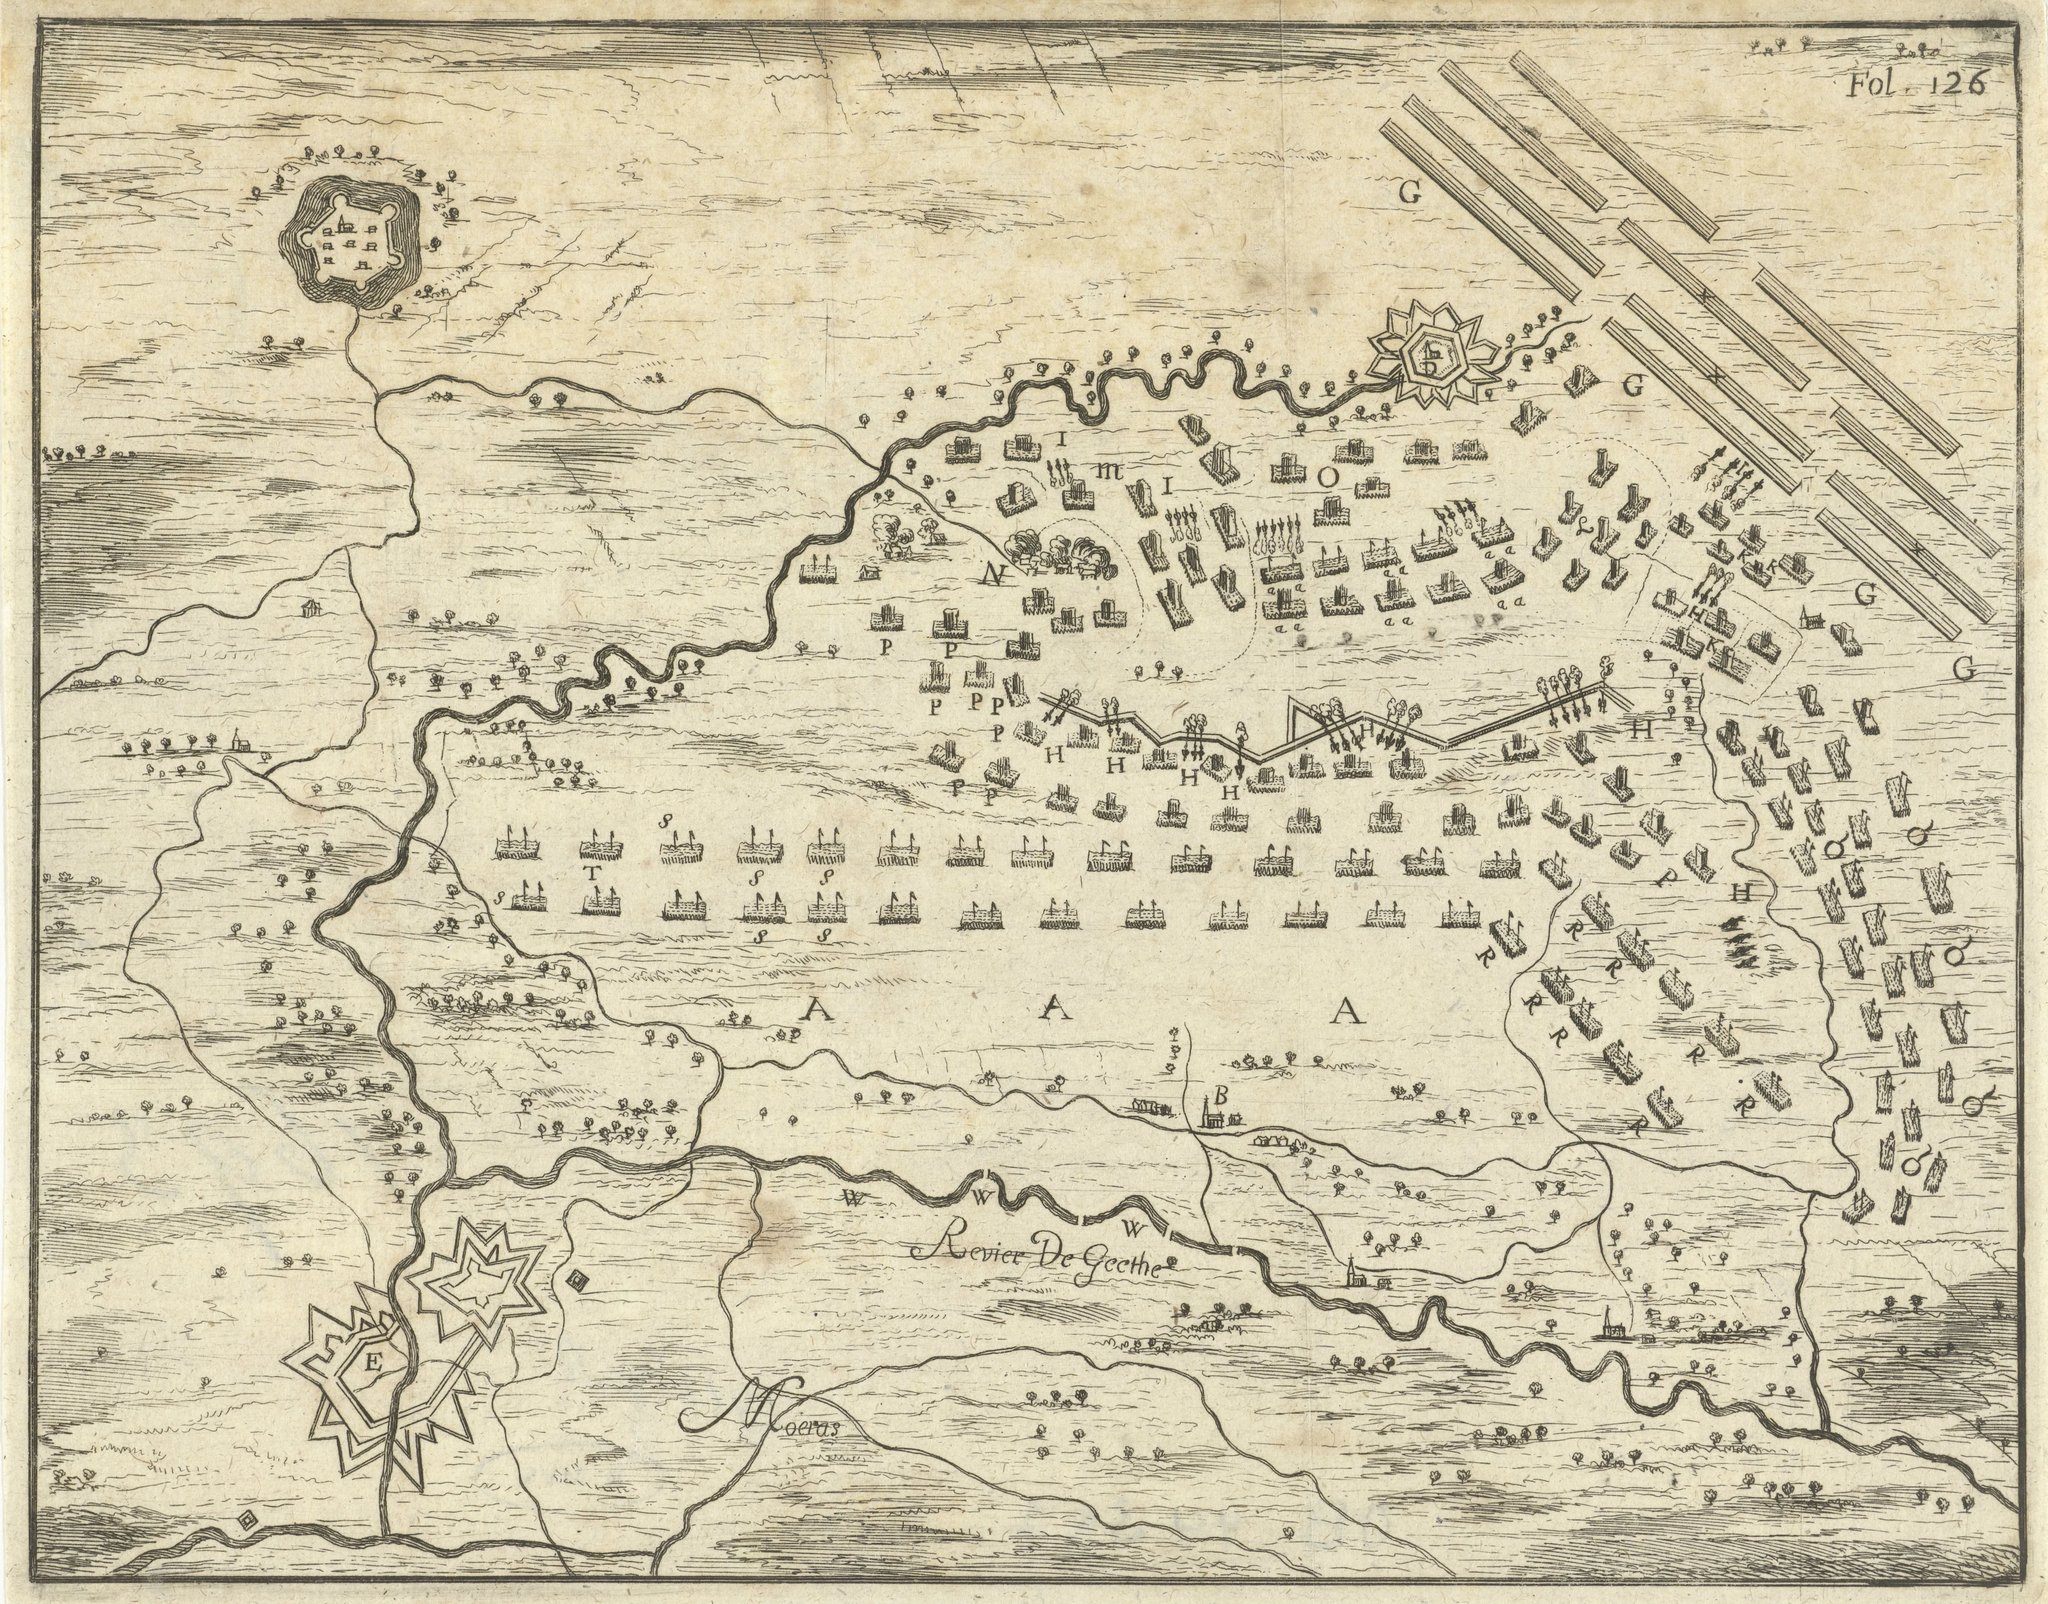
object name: print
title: Plattegrond van de Slag bij Landen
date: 1693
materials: paper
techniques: etching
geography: amsterdam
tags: maps of separate countries or regions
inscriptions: collector's mark: Lugt 2228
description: Illustratie uit: Europische Mercurius, behelzende al het voornaamste 'tgeen, zo omtrent de zaaken van staat als oorlog (...) is voorgevallen (...). Vierde Stuk, begrypende (...) het jaar 1693. Amsterdam: Timotheus ten Hoorn, 1693, dl. II.